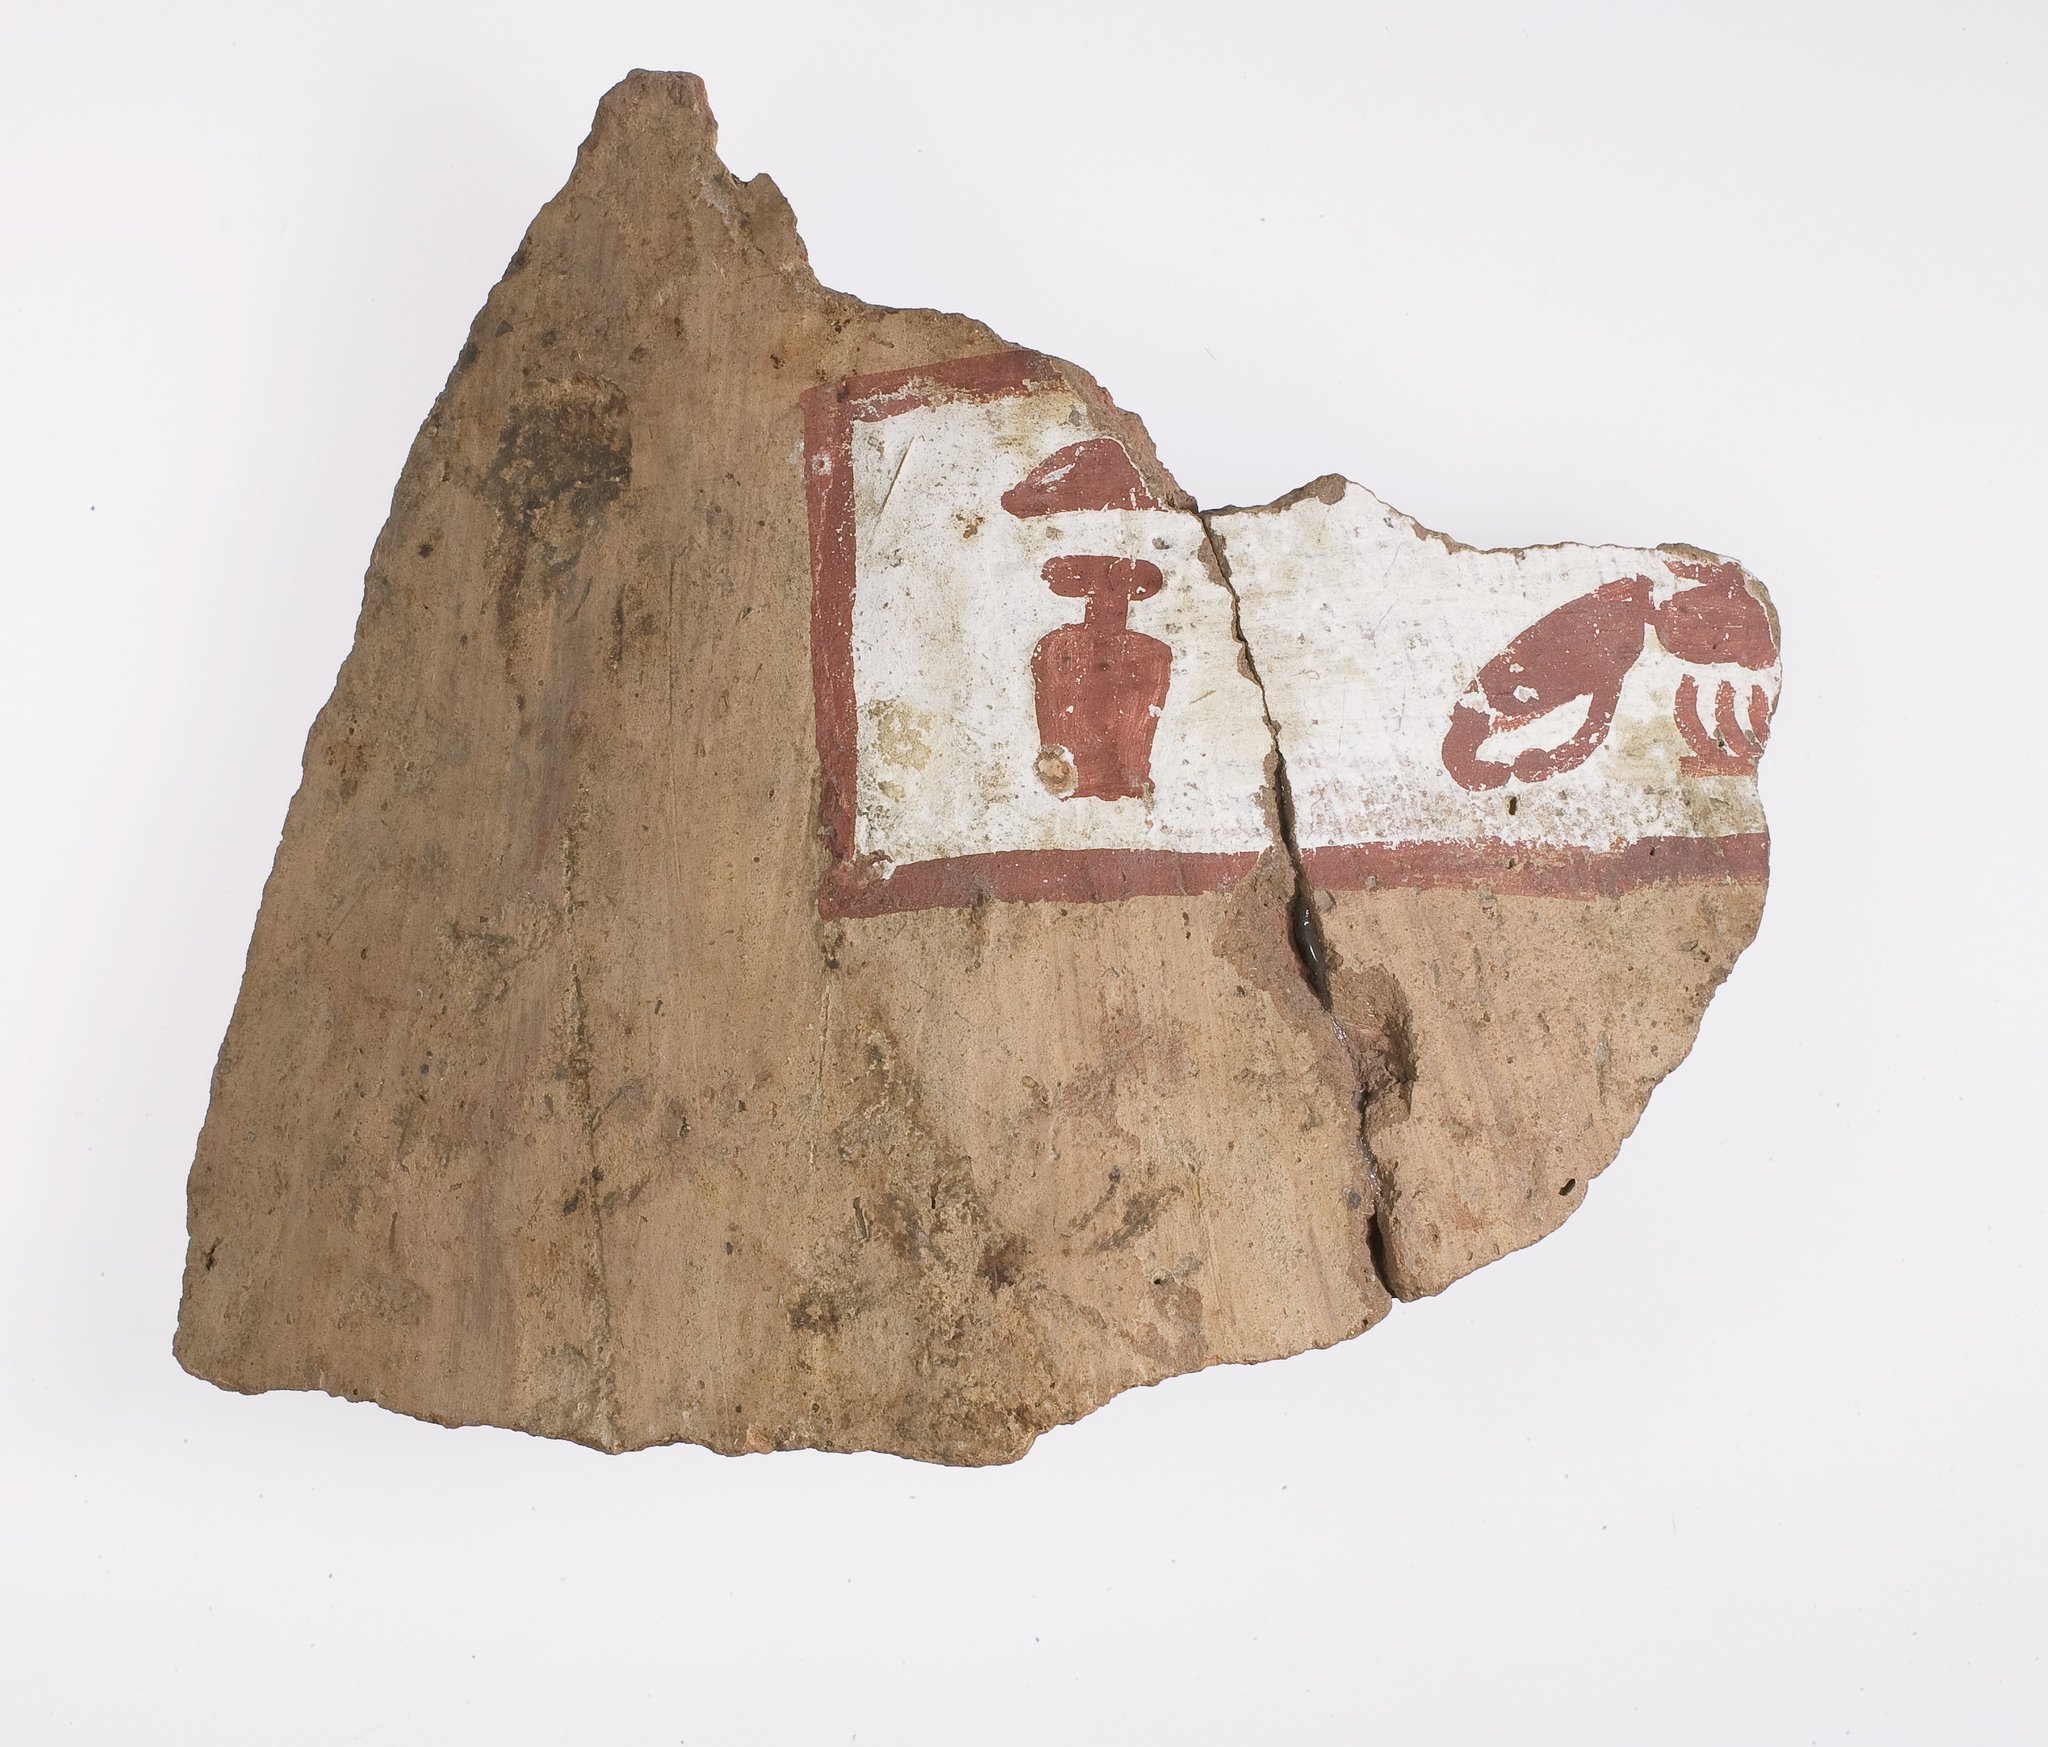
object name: vessel fragment, inscribed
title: Fragment of inscribed vessel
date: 1550-1295 BCE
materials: pottery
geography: egypt